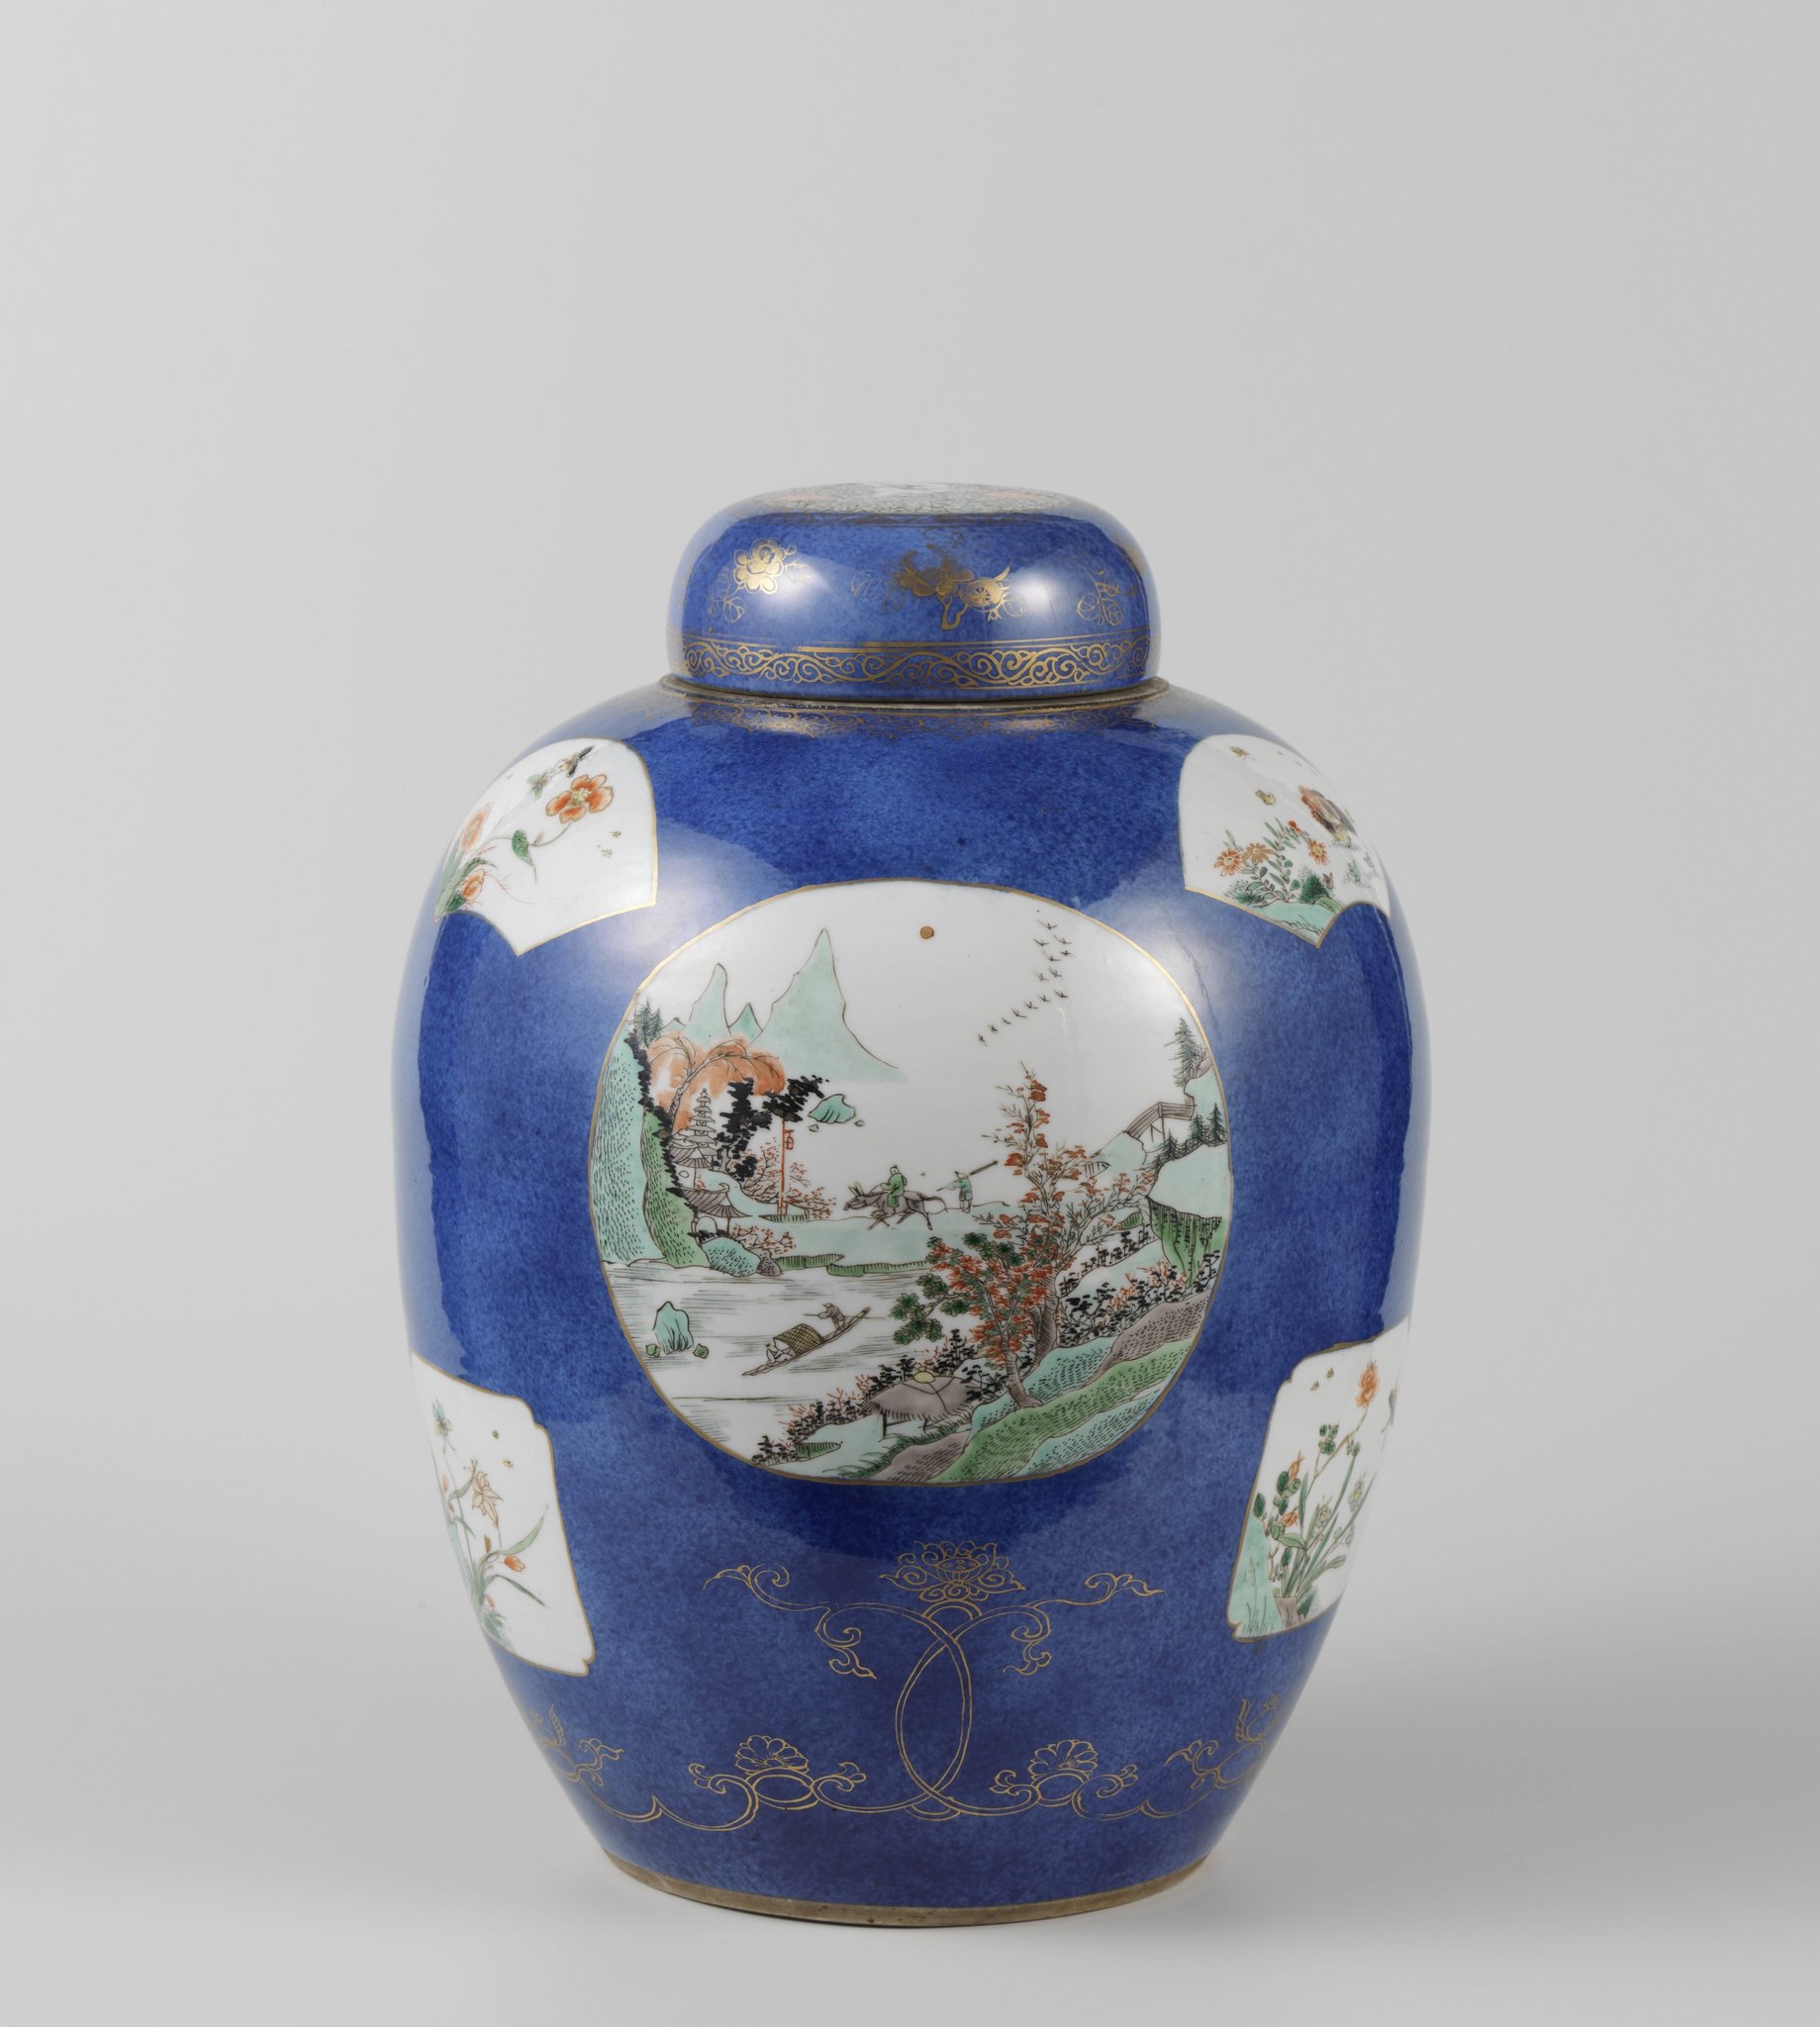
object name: covered jar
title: Ovoid covered jar with powder blue and panels in reserve with lanscape, flower basket and antiquities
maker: Anonymous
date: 1700-1724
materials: cobalt, glaze, gold, paint, porcelain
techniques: firing, gilding, turning, vitrification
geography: china